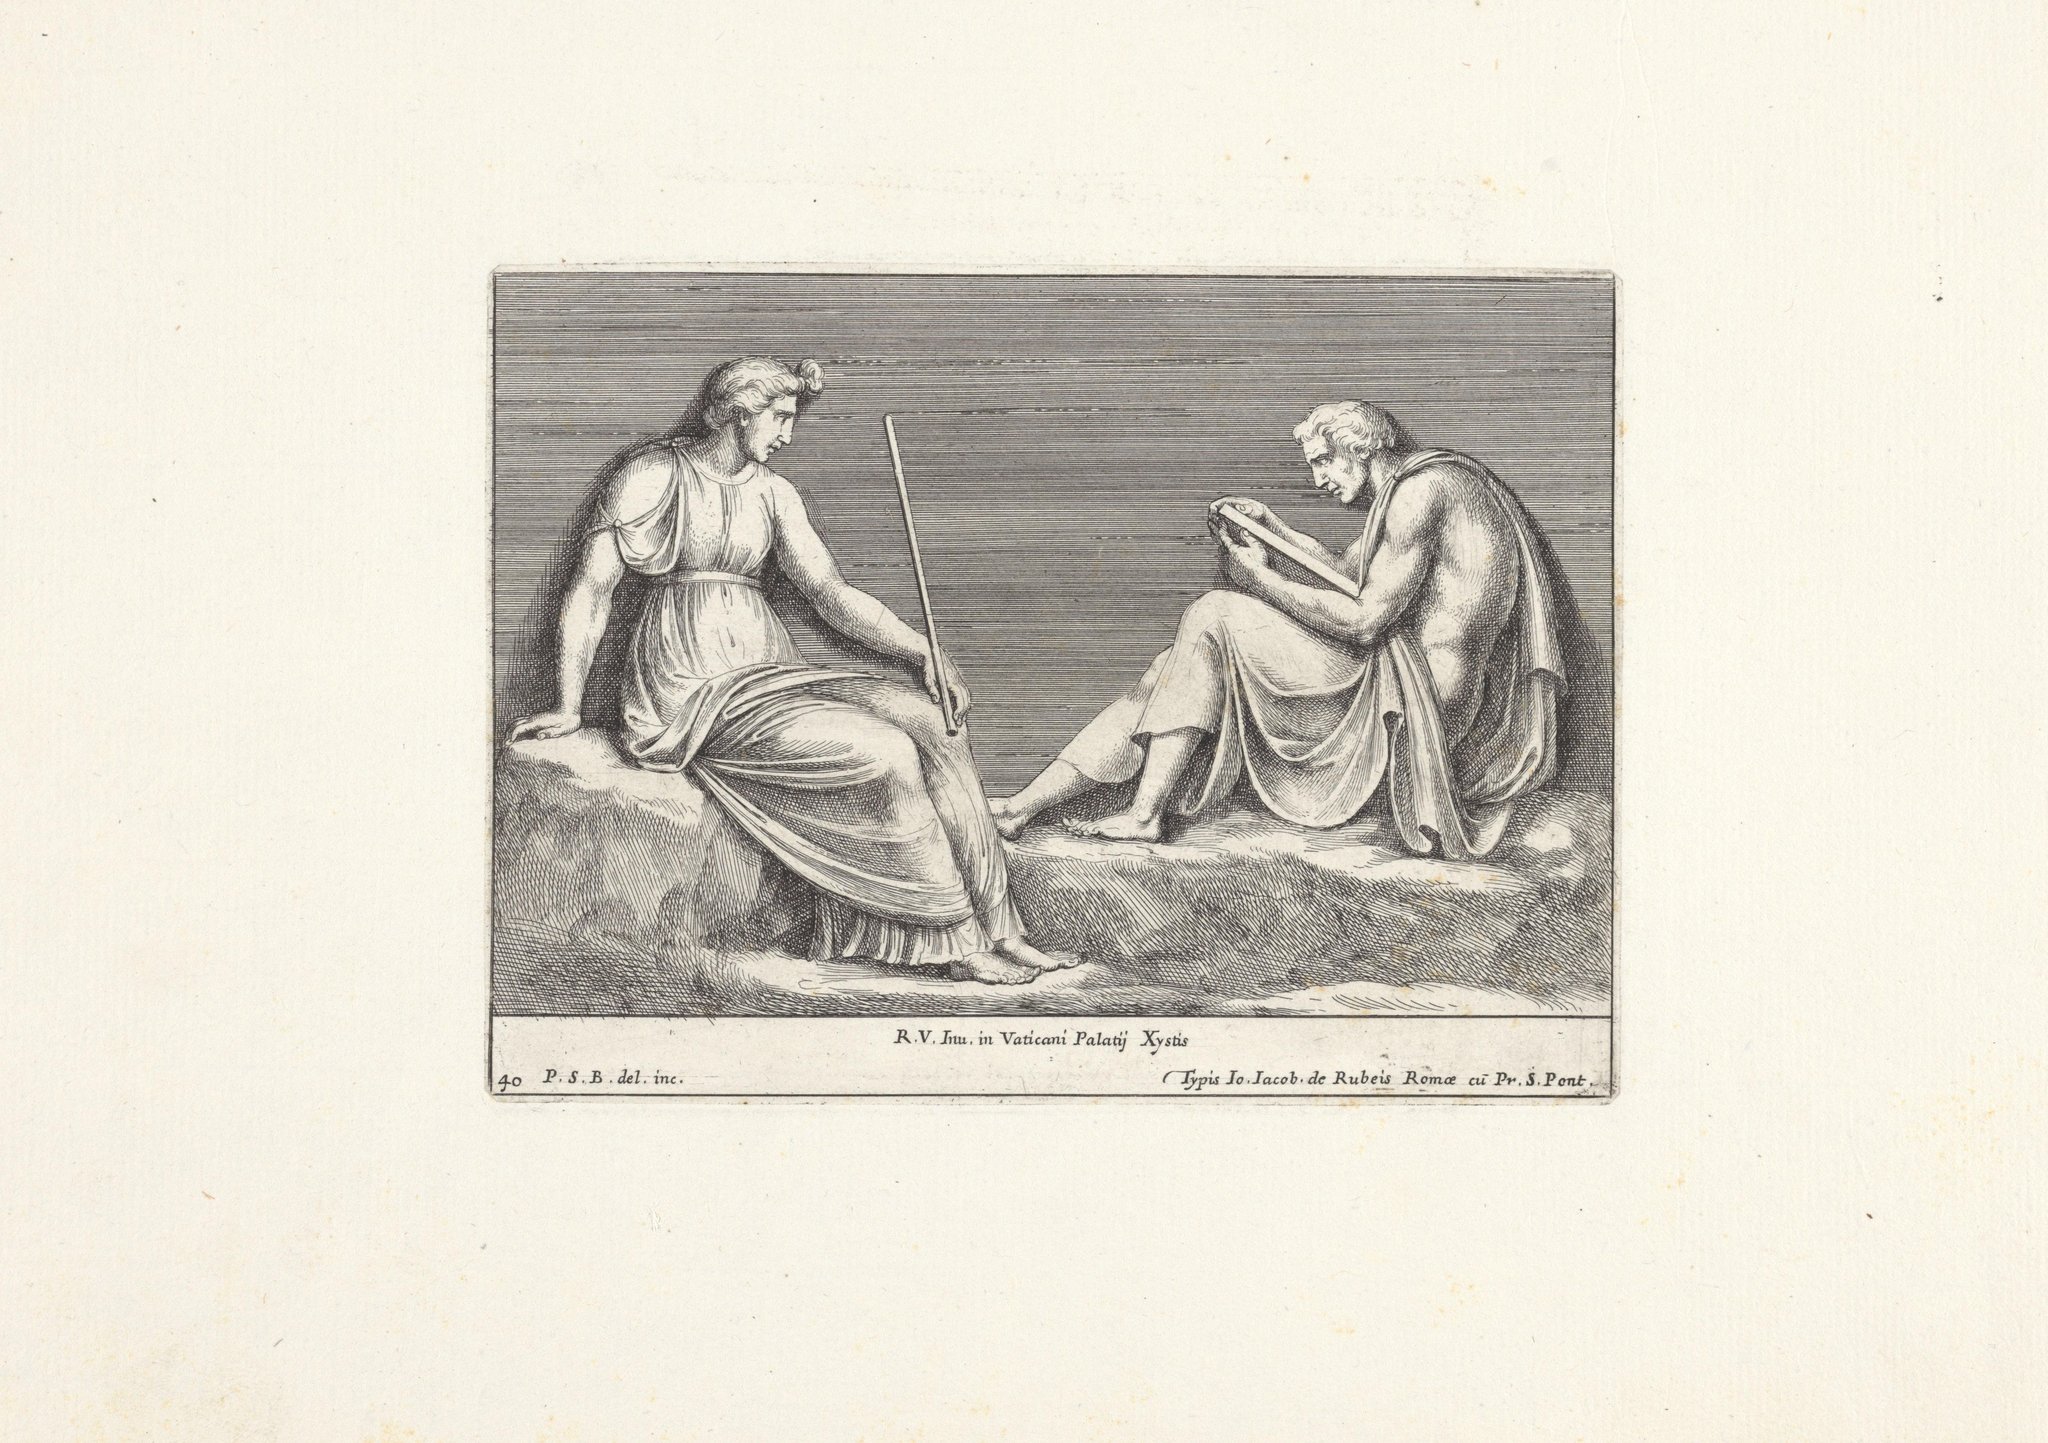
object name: print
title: Zittende man en vrouw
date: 1645-1700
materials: paper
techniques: engraving, etching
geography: vatican city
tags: writing tablets, sitting on an elevation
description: Prent uit een reeks naar de gipsen reliëfs door Rafaël en uitgevoerd door zijn assistenten in de Vaticaanse Loggia.